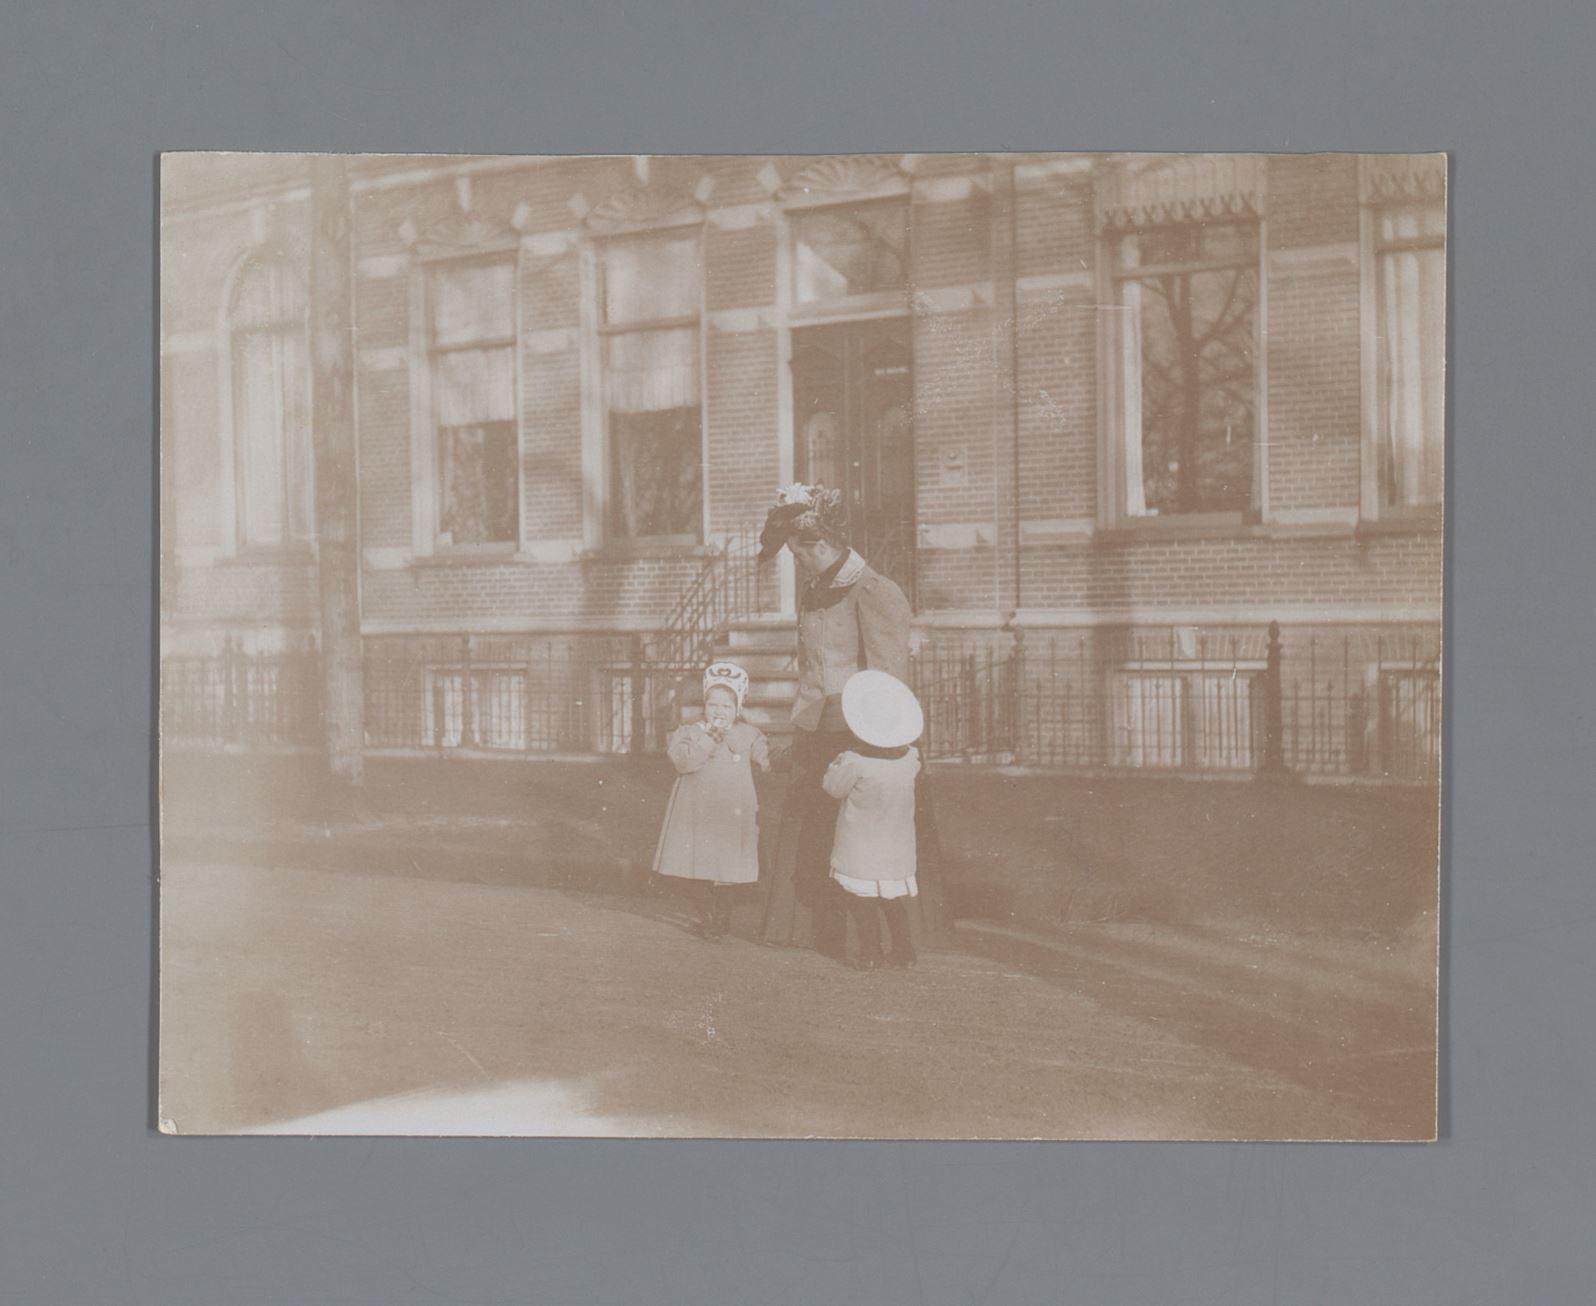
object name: photograph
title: Vrouw op straat met twee kinderen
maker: johannes diderik van der waals (1873-1971)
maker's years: 1873-1971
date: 1900-1920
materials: photographic support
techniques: collodion silver print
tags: historical persons - bb - woman, child, anonymous historical persons portrayed in a group, in a group-portrait